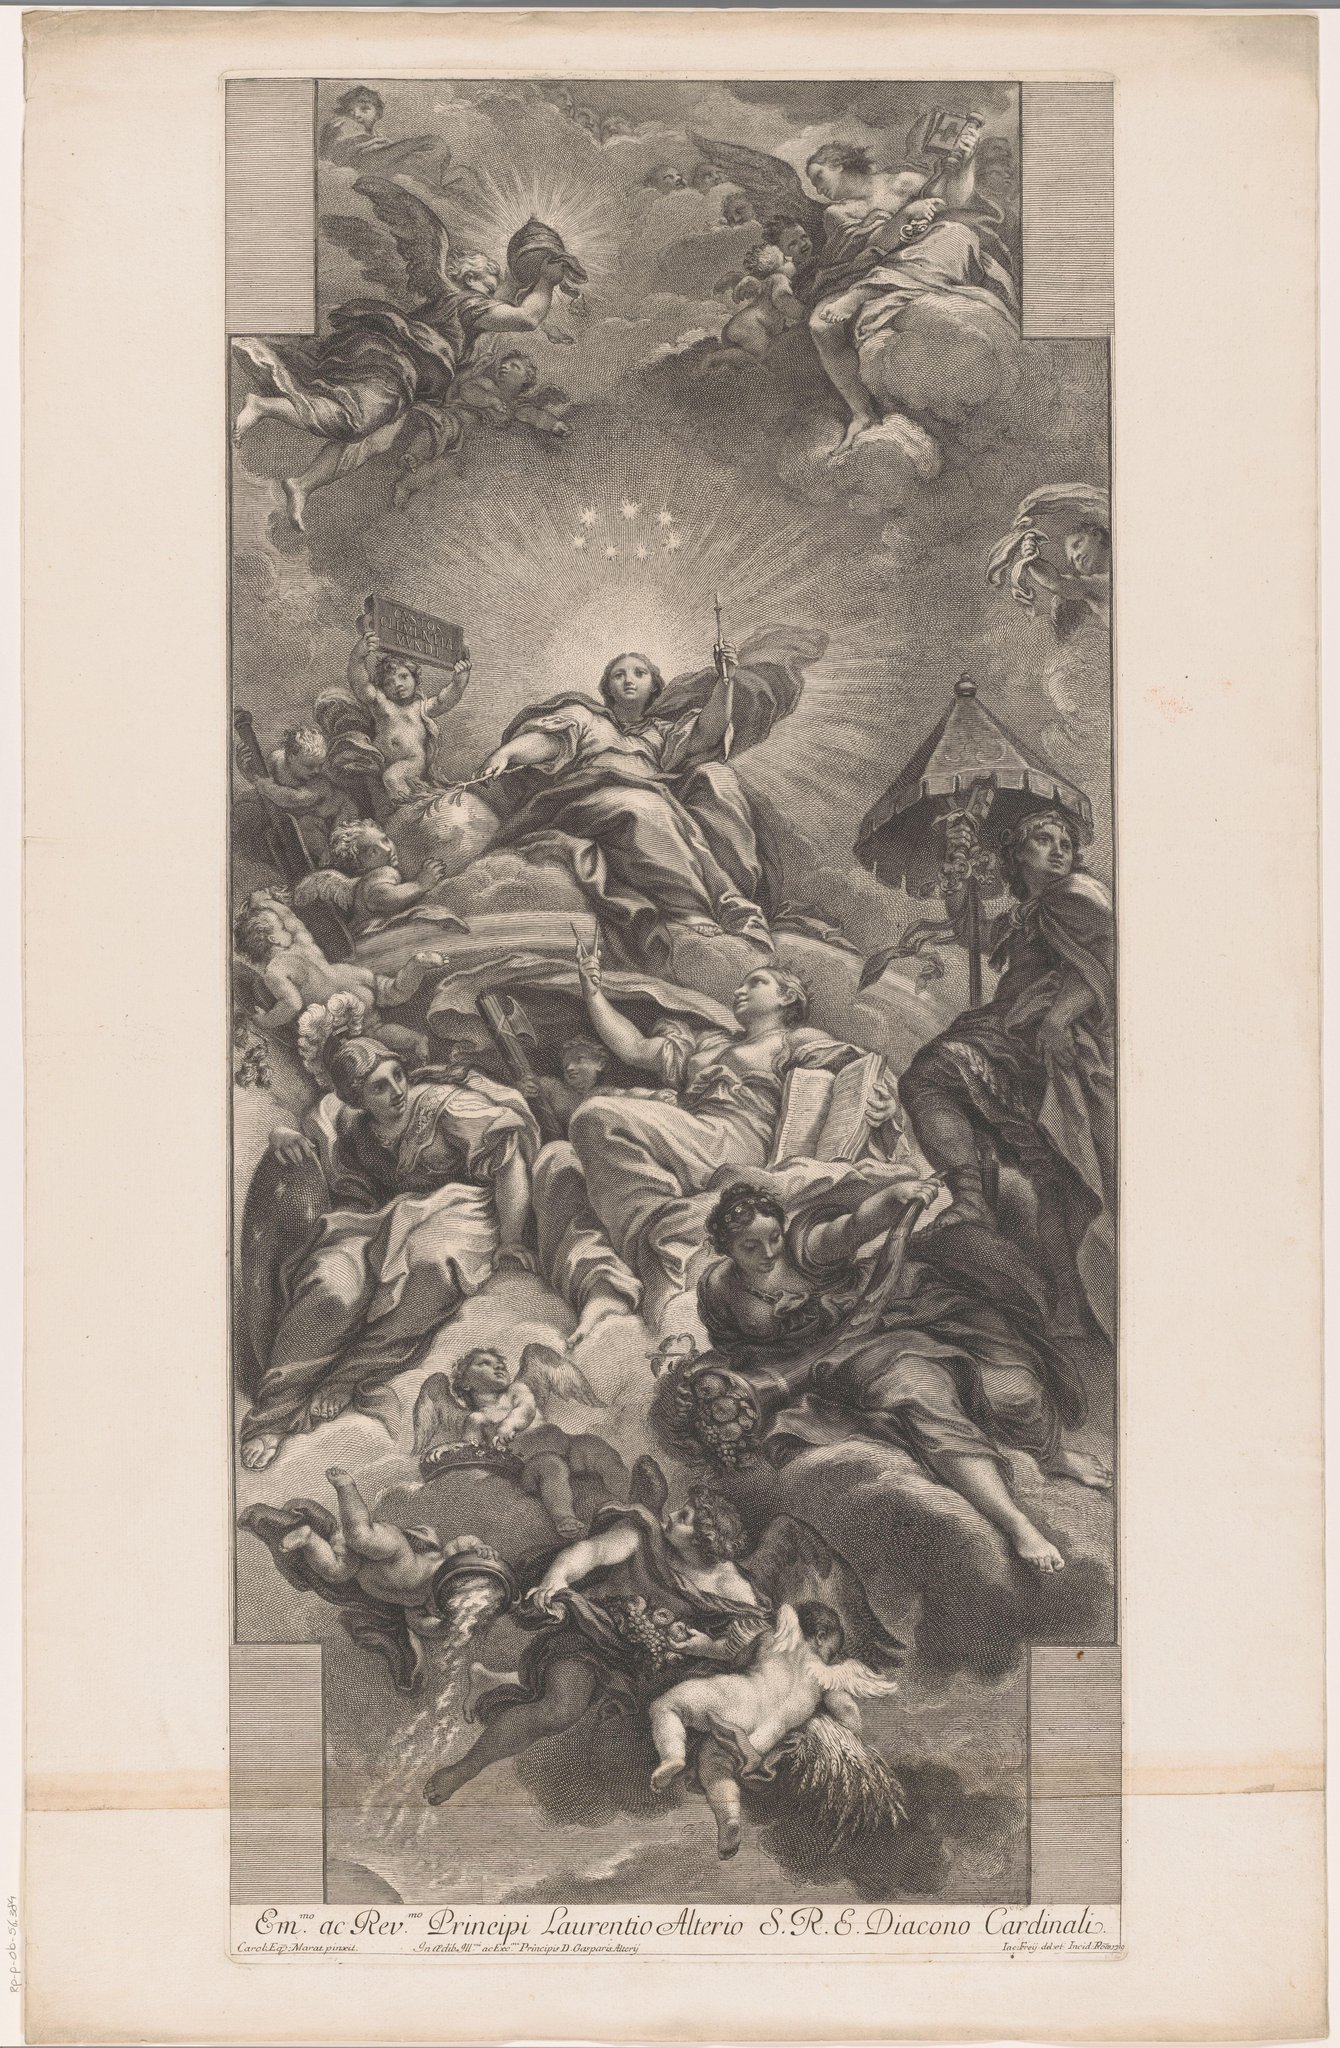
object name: print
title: Custos Clementia Mundi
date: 1719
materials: paper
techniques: engraving, etching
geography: rome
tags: (story of) ceres (demeter), (story of) minerva (pallas, athena), key, angels, indulgence, clemency; 'clemenza', 'clemenza & moderatione', 'indulgenza' (ripa)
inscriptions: collector's mark: Lugt 240